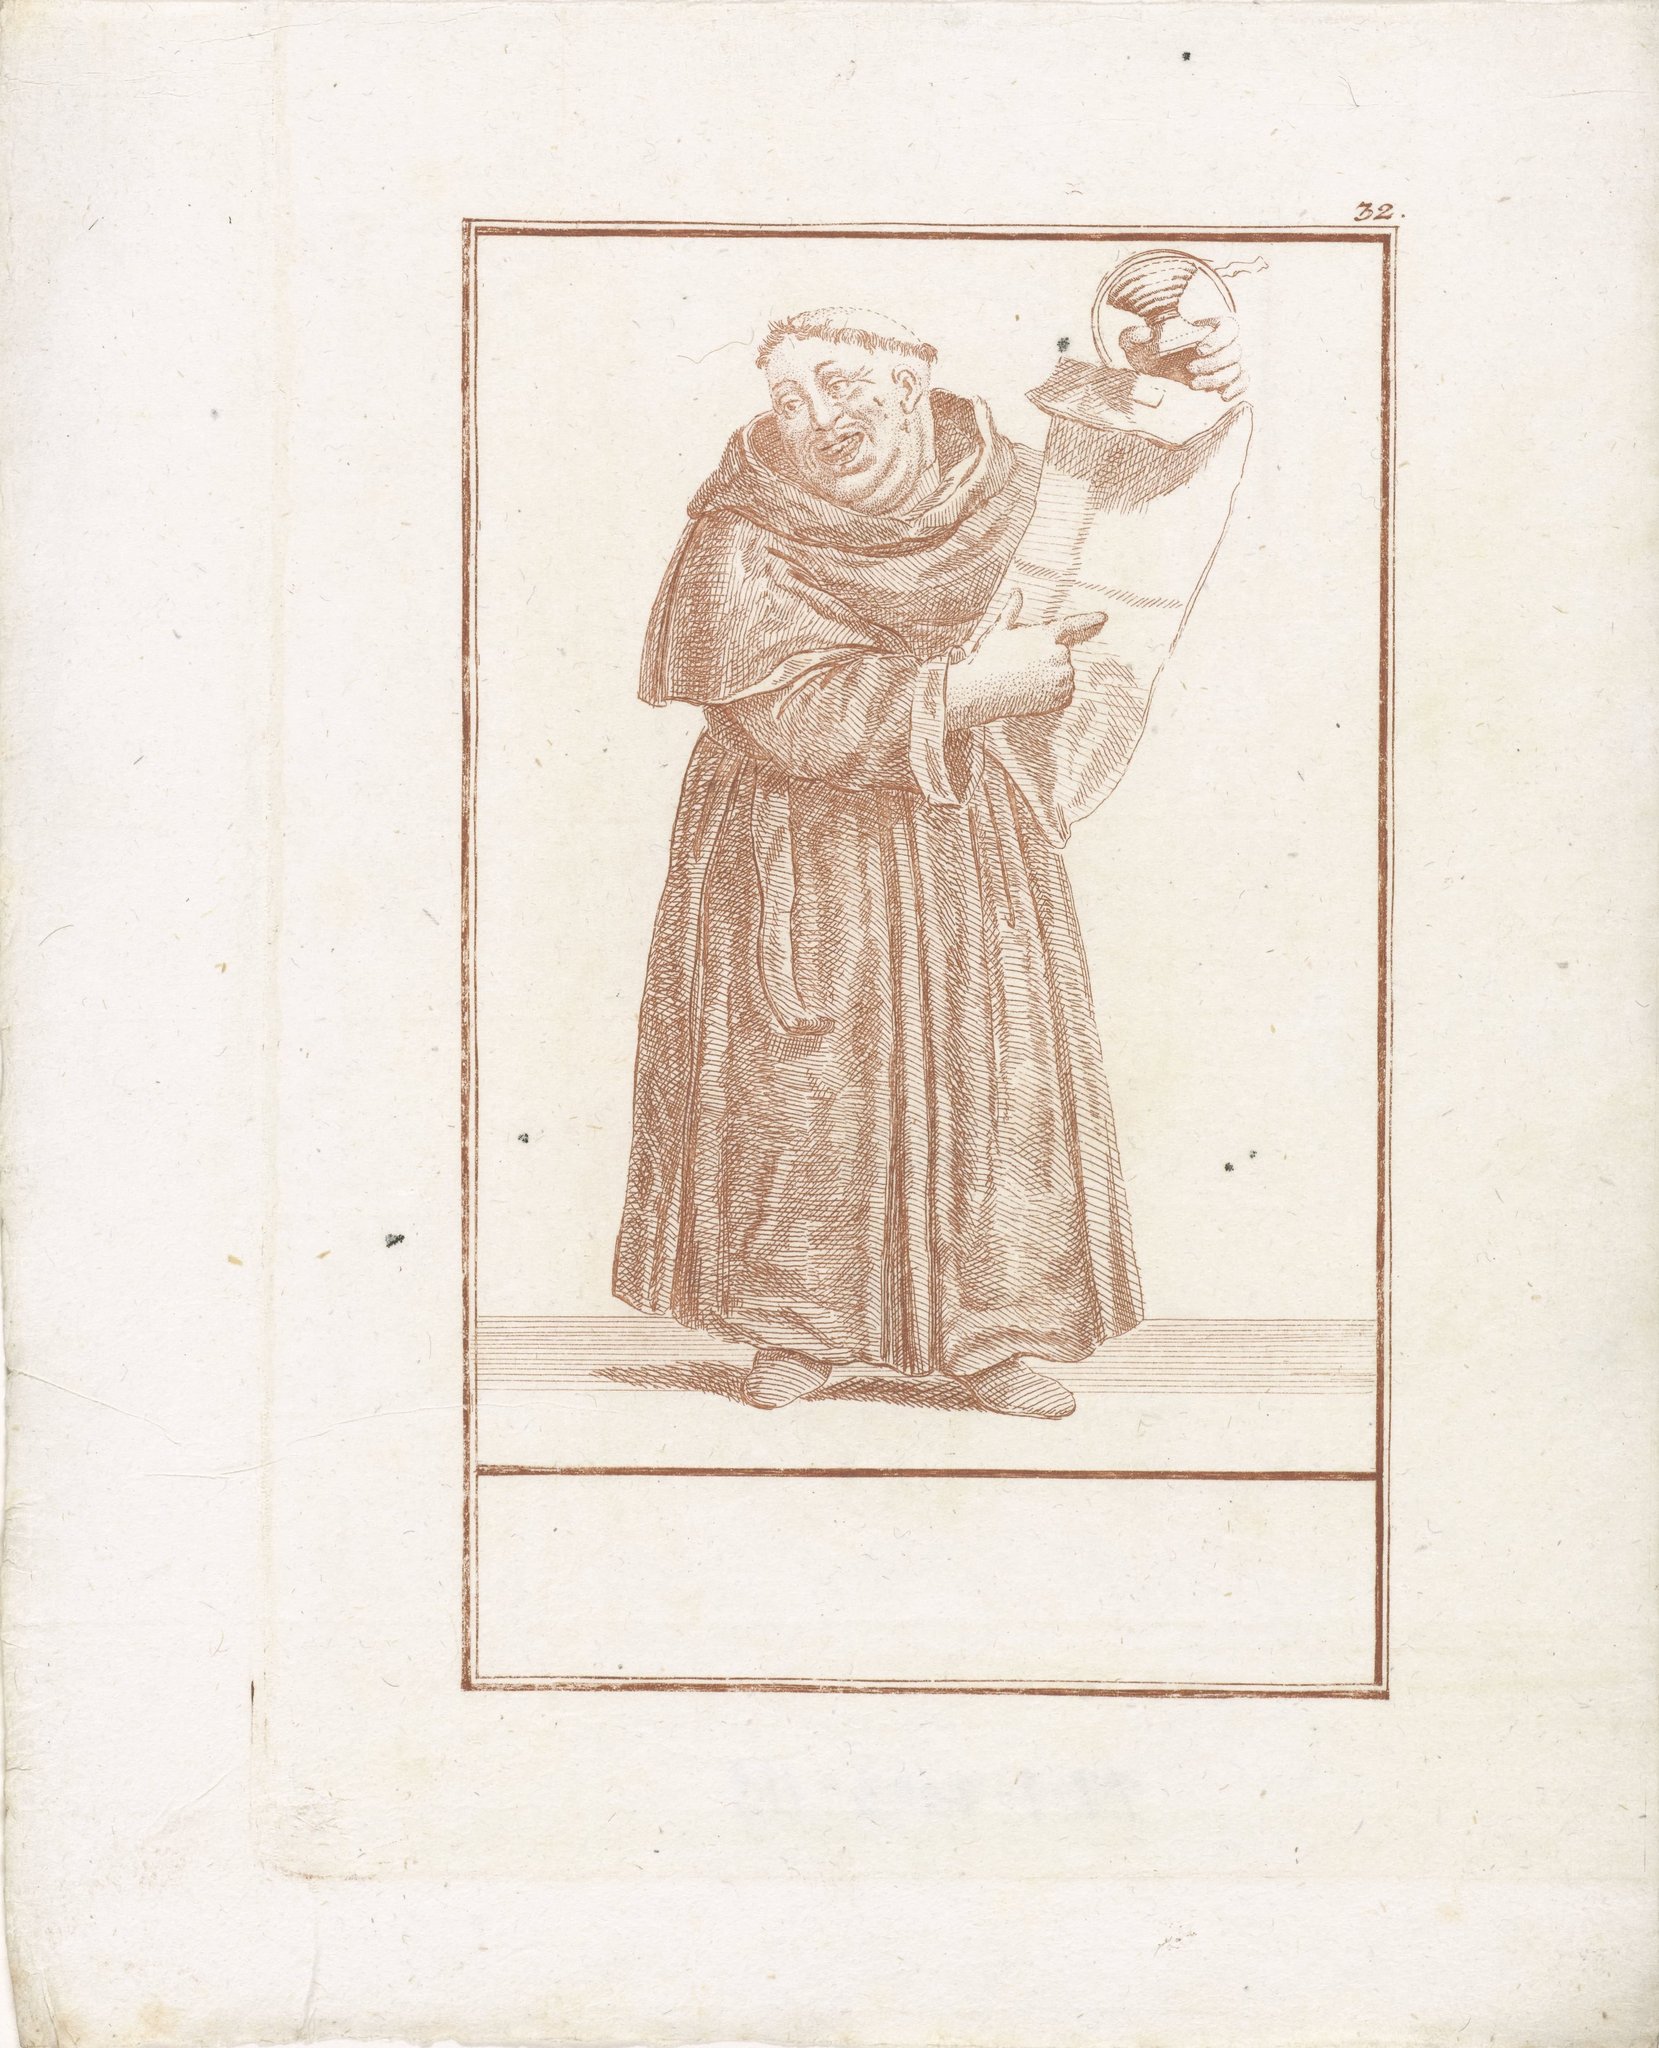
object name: cartoon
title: L'Abregé du Faux Clerge Romain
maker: jacob gole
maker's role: print maker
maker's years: 1660-1724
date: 1724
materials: paper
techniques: etching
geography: amsterdam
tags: possession, monk(s), friar(s), (aspects of) christian religion or the church (as institution) ridiculed, criticized, or caricaturized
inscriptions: collector's mark: Lugt 2760, collector's mark: Lugt 2228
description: Staande monnik, wijzend met zijn rechterhand op een eigendomsakte die hij samen met een wijnbeker in zijn linkerhand houdt. De prent is deel van een 50-delige serie met als onderwerp de misbruiken van de katholieke geestelijkheid.